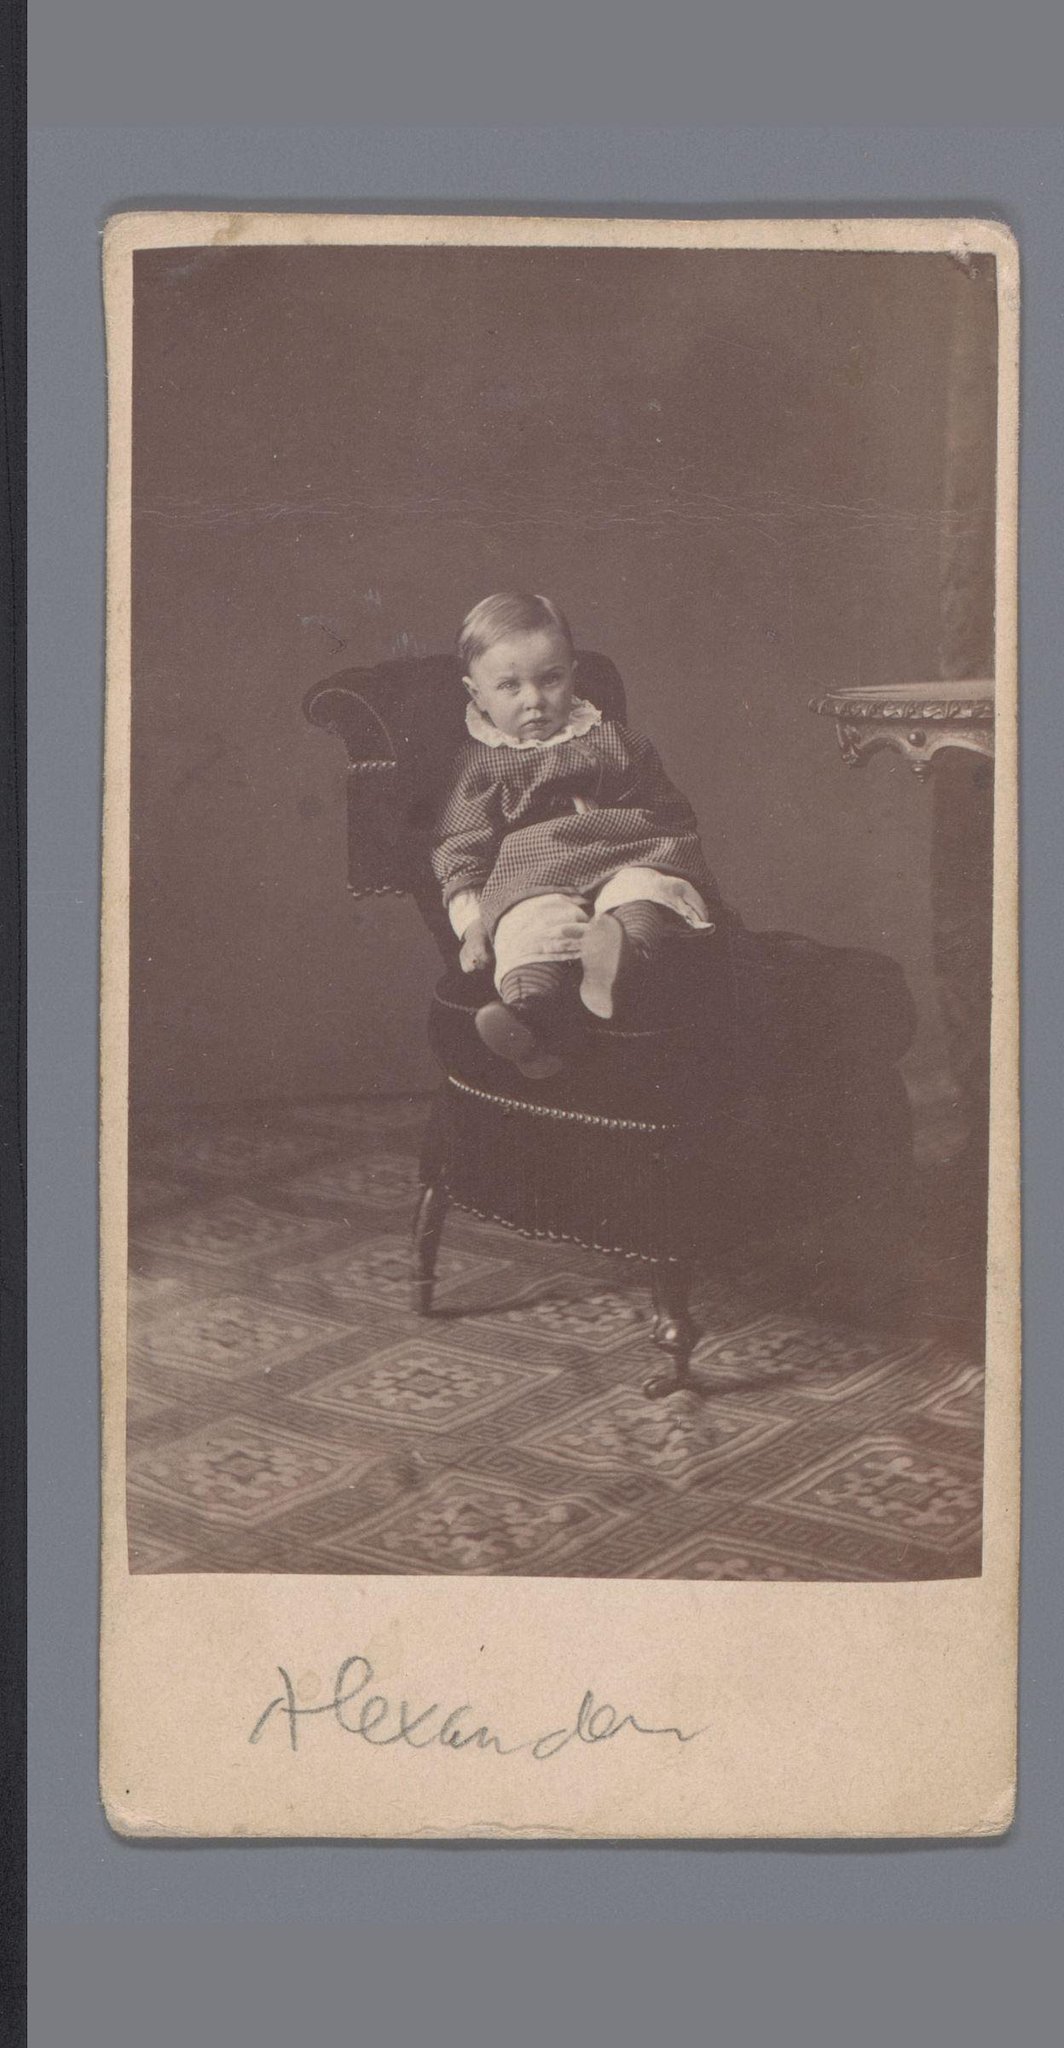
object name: photograph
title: Portret van een jongen, aangeduid als Alexander, zittend in een stoel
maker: lindman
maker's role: fotograaf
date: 1863-1866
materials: cardboard, paper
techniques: albumen print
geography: stockholm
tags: sitting figure, boy (child between toddler and youth), anonymous historical person portrayed, chair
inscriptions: inscription: ‘Alexander’, inscription: ‘FOTOGRAFISK ATELIER/ LINDMAN/ Wahrendorffsgatan No. 8/ vid. Berzelii park.’